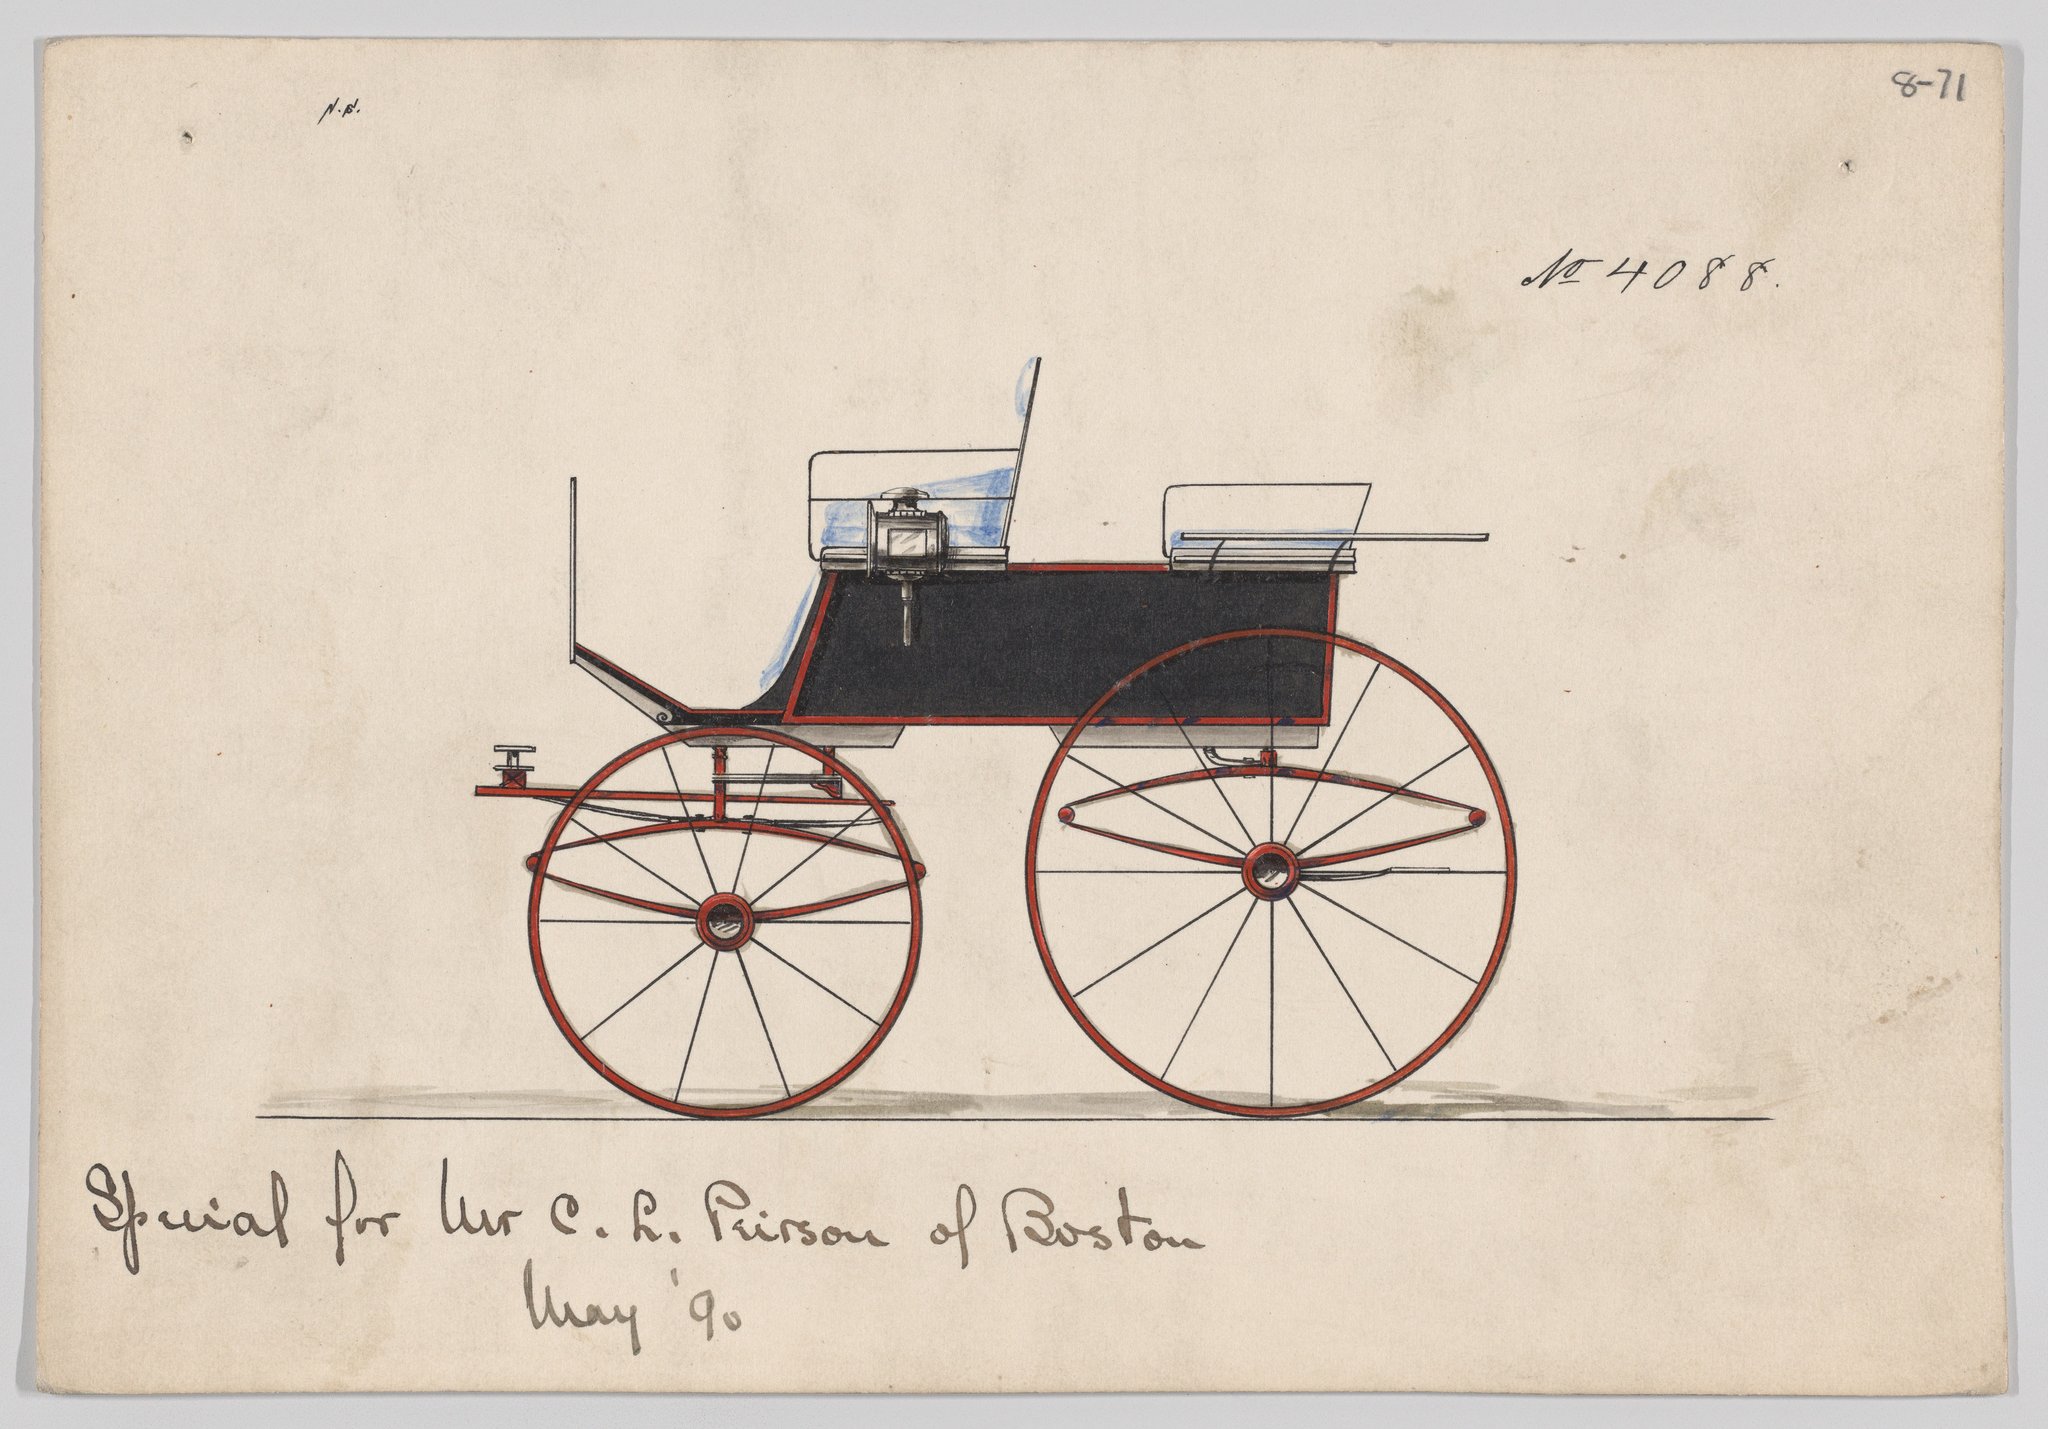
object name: drawing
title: Design for 4 seat Phaeton, no top, no. 4088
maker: brewster & co.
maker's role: manufacturer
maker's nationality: american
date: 1890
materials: gouache, gum arabic, ink, watercolor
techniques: pen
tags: carriages